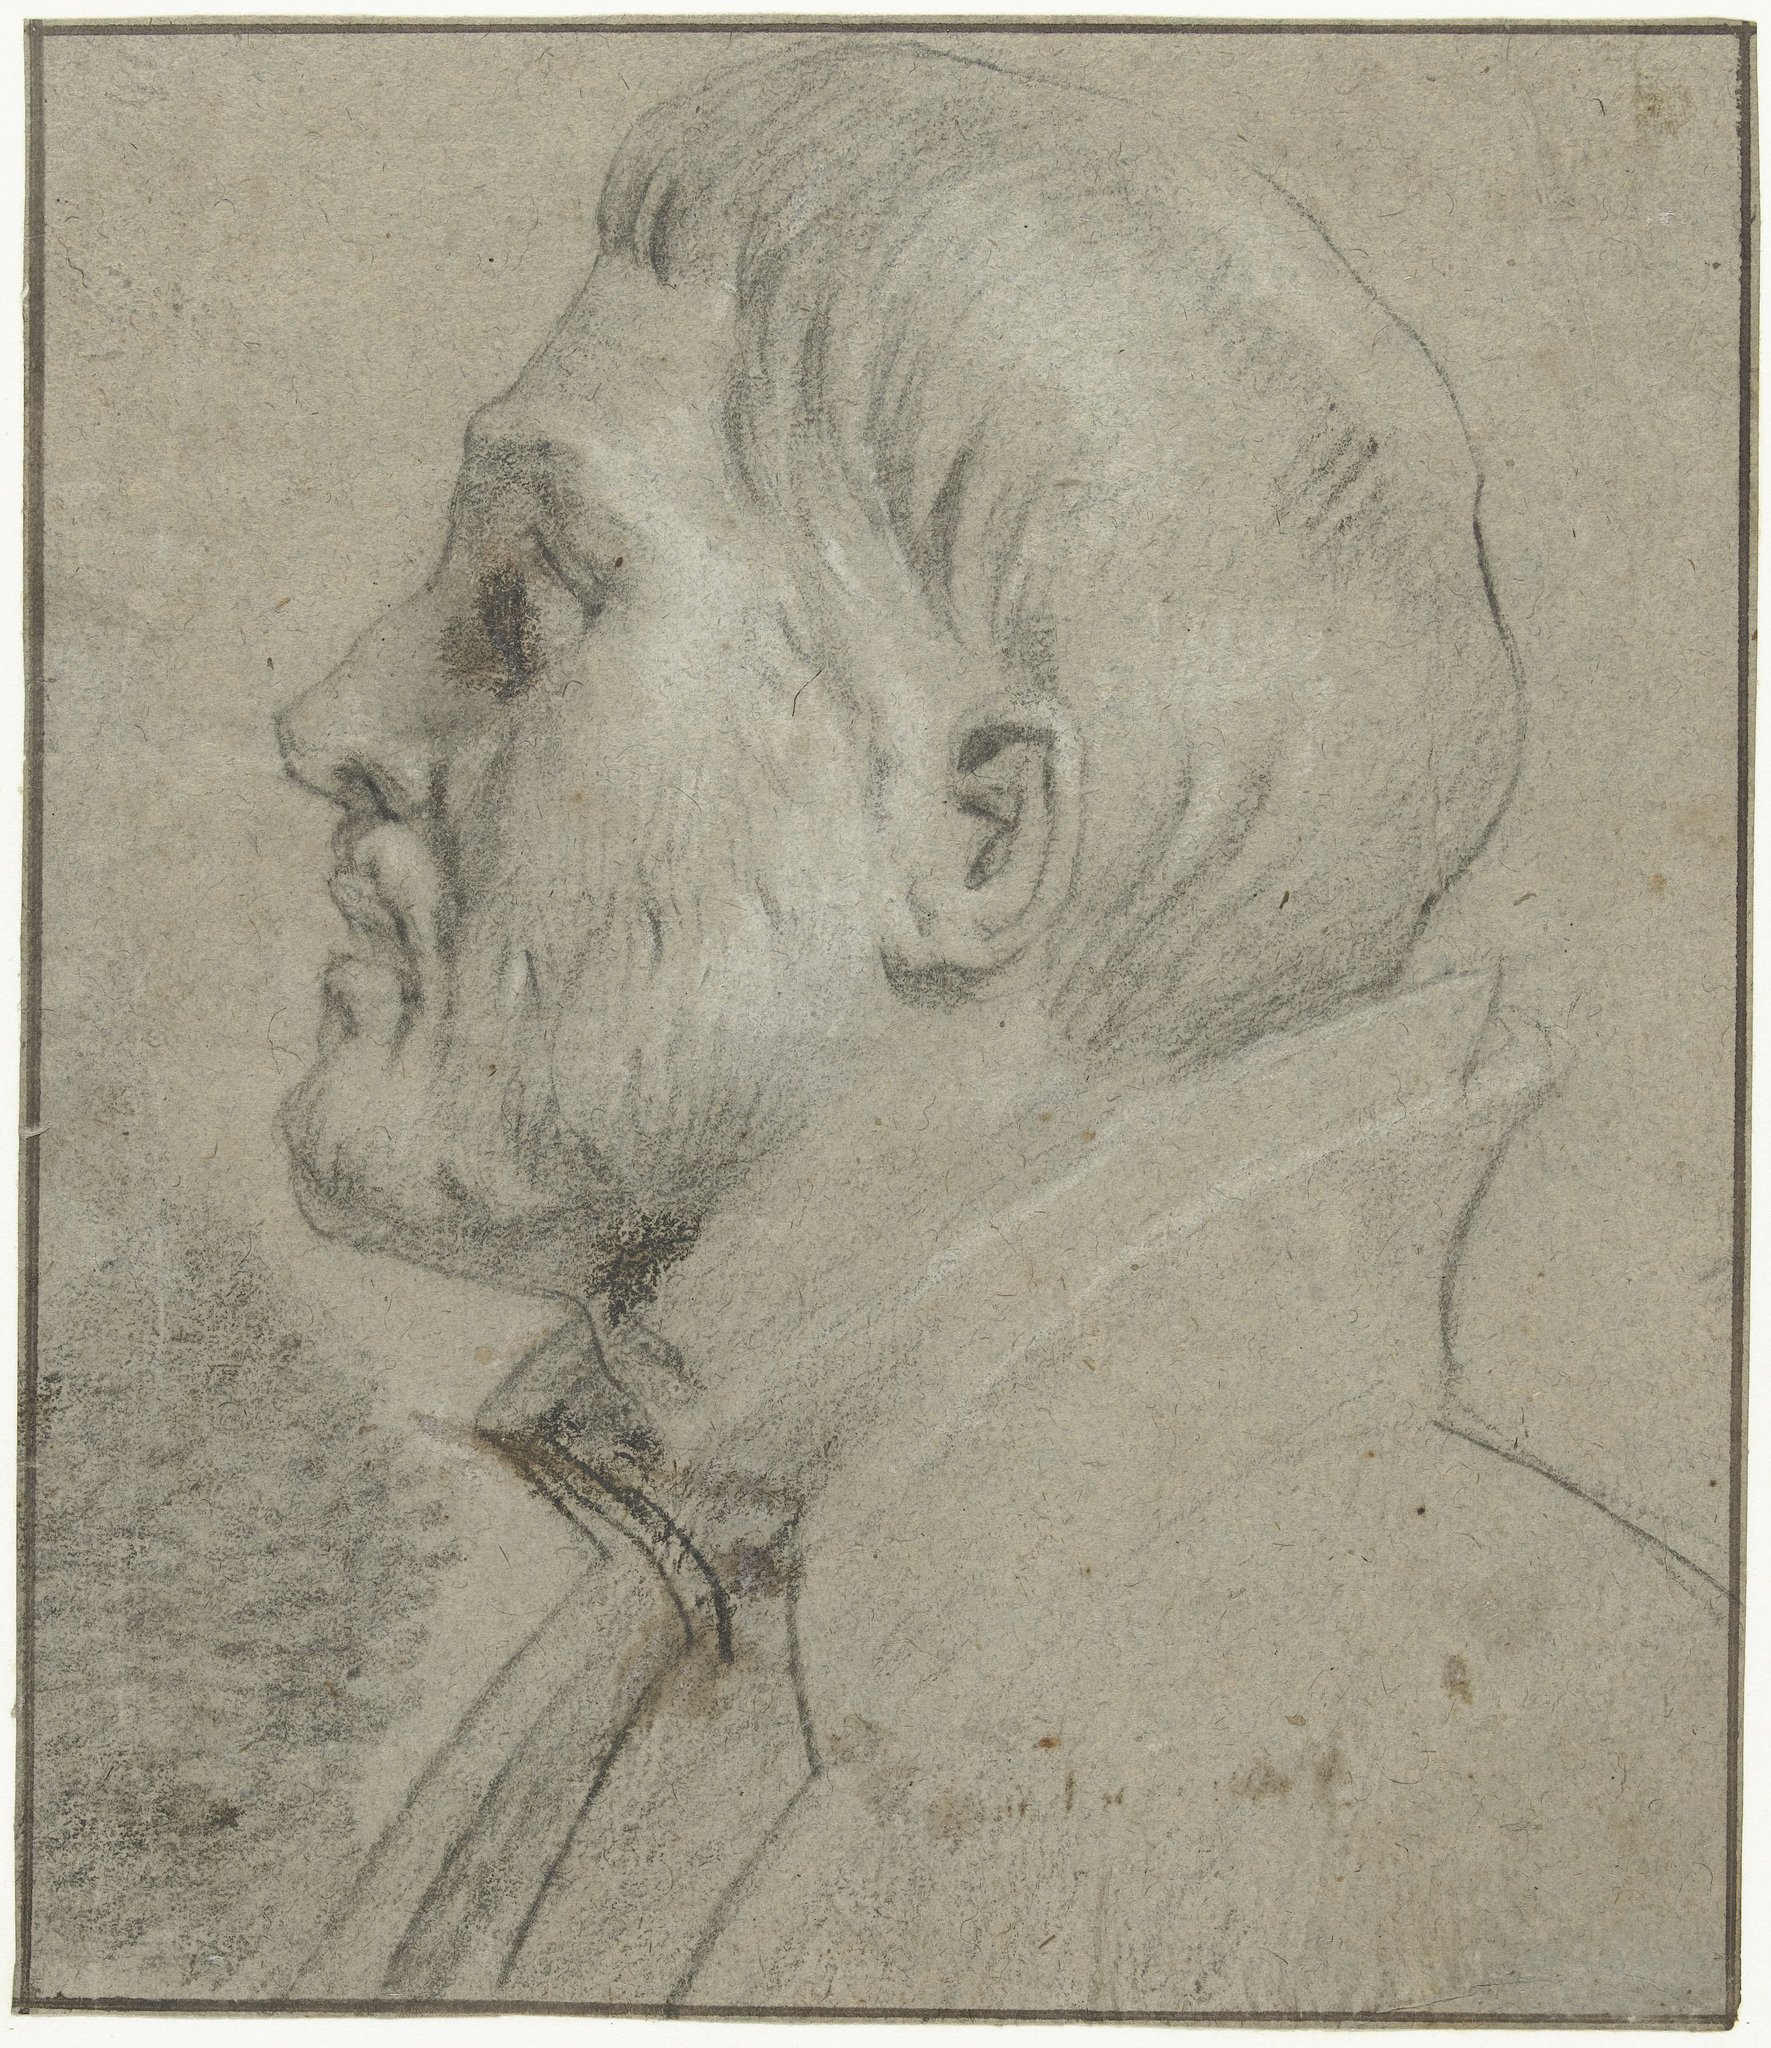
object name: drawing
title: Kop van een man met opstaande kraag, in profiel naar links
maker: gaspar de crayer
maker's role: draughtsman, print maker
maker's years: 1584-1669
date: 1594-1669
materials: chalk, paper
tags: head (human), male sex; man